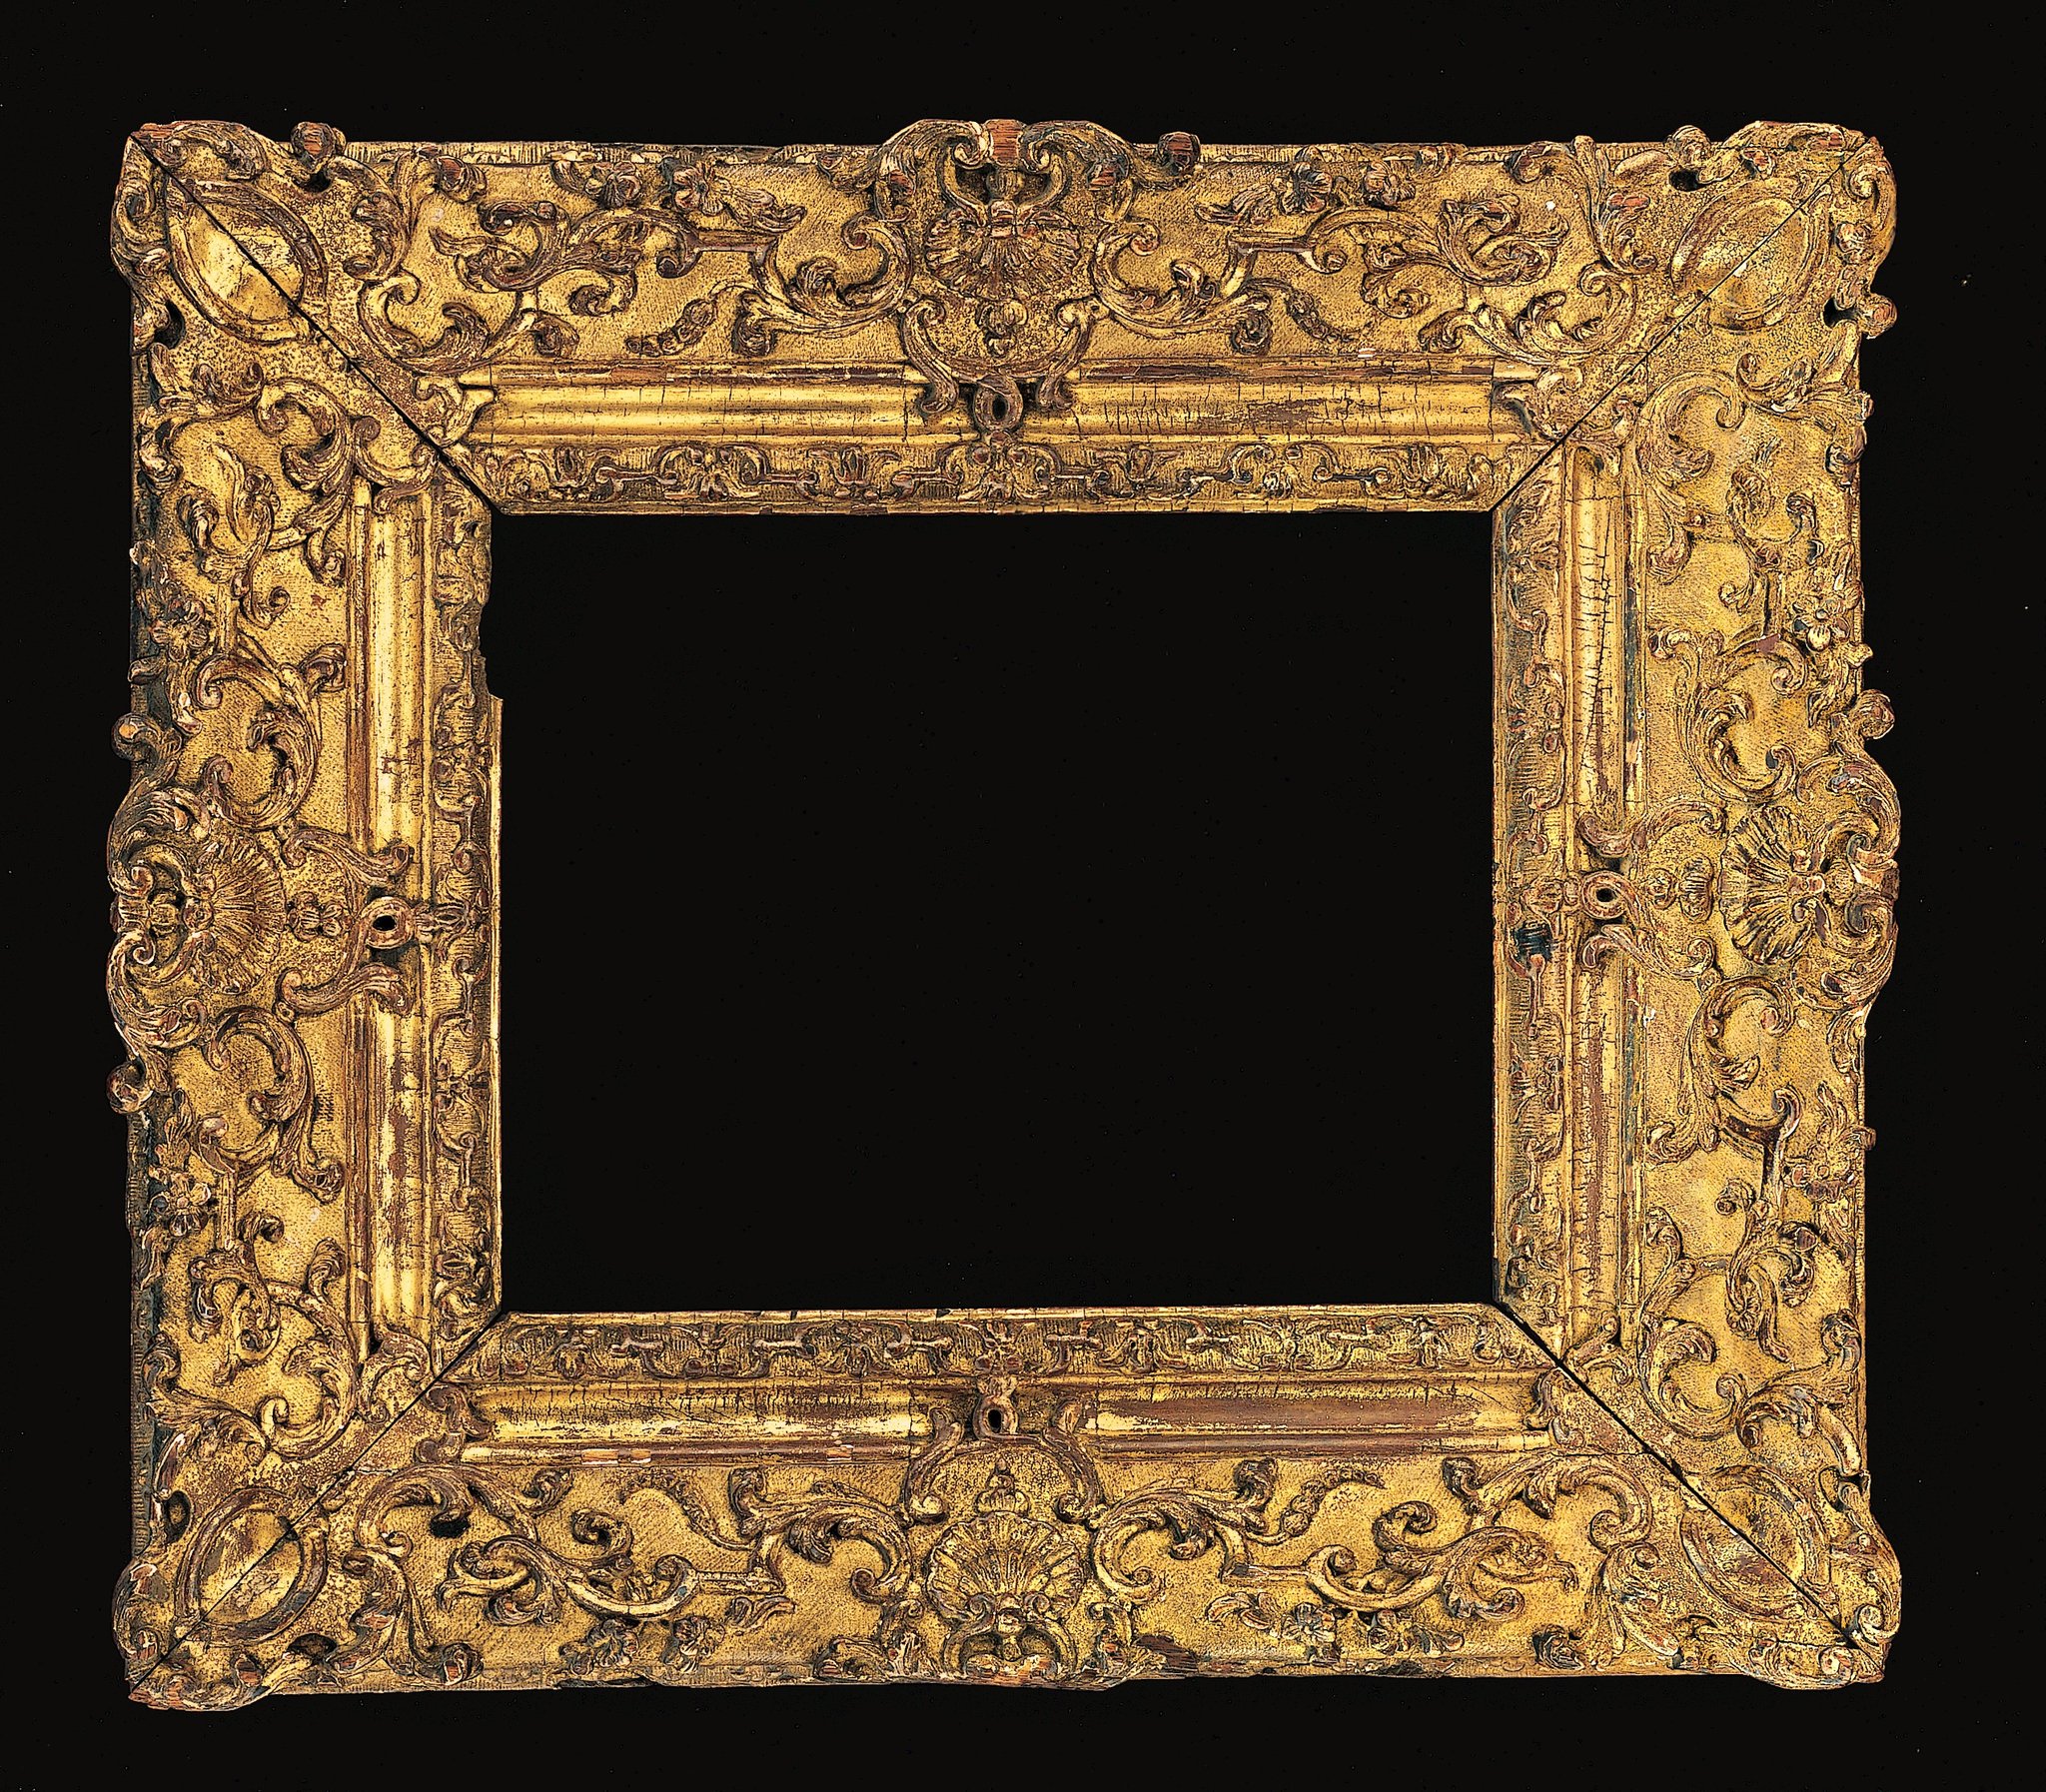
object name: frame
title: Ogee frame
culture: french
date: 1690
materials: wood